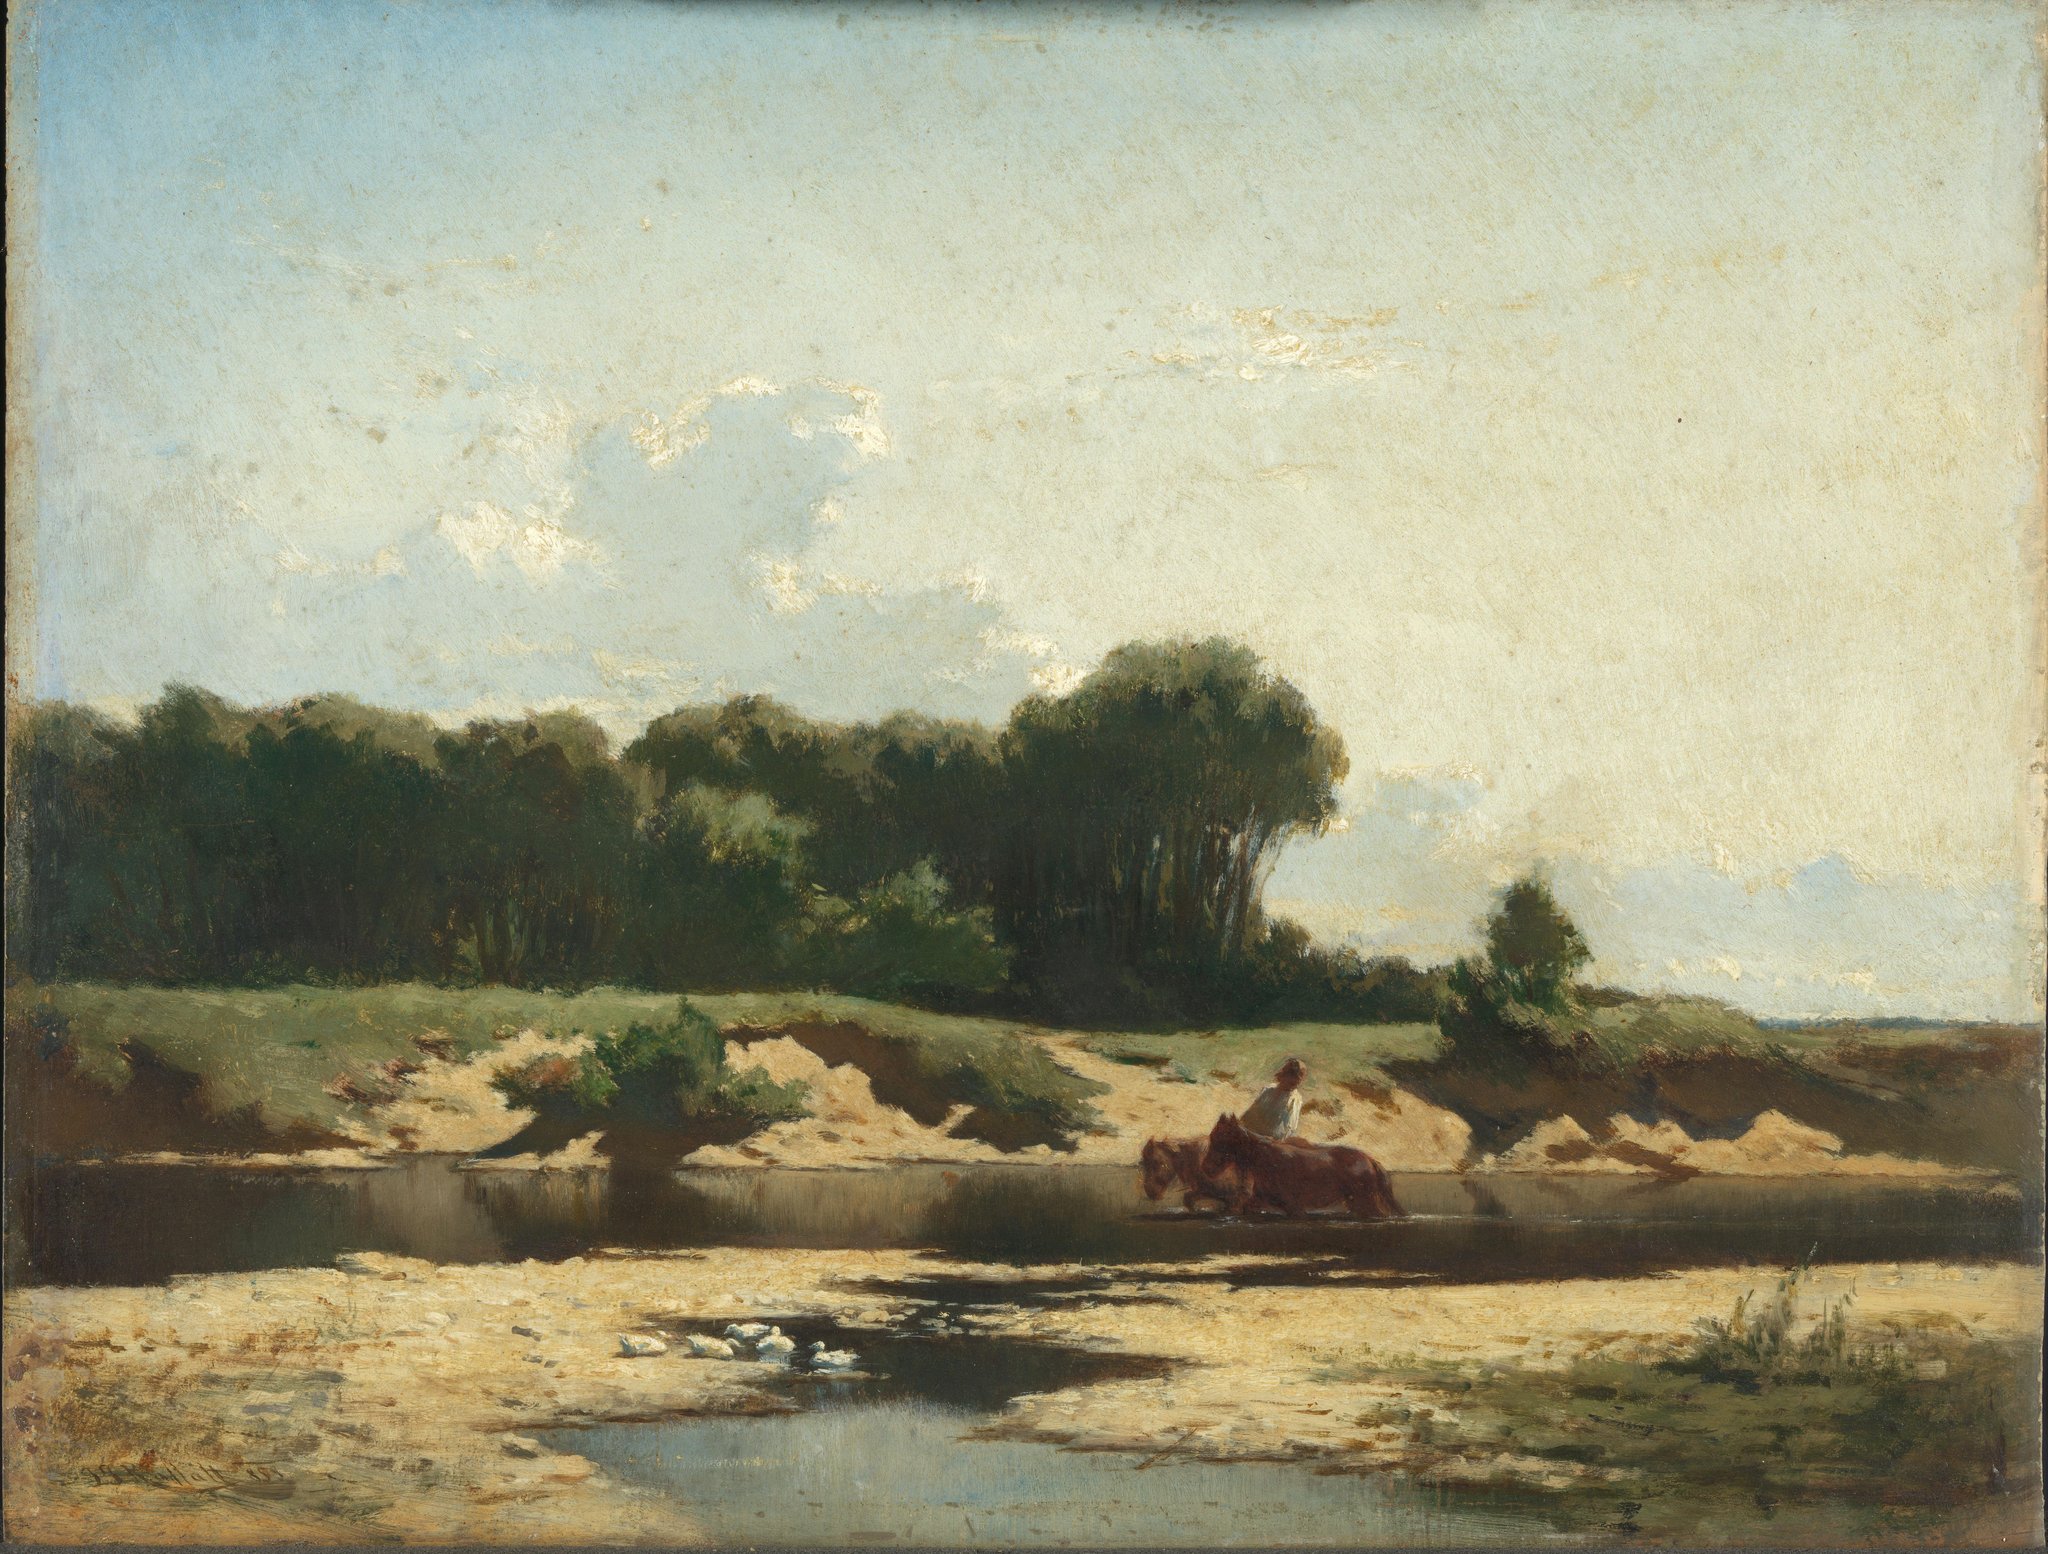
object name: painting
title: Het paardenwed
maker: johann gualbert raffalt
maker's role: painter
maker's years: 1836-1865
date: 1858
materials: oil, panel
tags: crossing a river, ford, horse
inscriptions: signature and date: ‘J.G. Raffalt [1]858’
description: Landschap met paardenwed. Een ruiter leidt een los paard door een rivier, aan de overzijde zandbanken en de rand van een bos. Op de voorgrond een zandplaat met eendjes bij de waterkant.